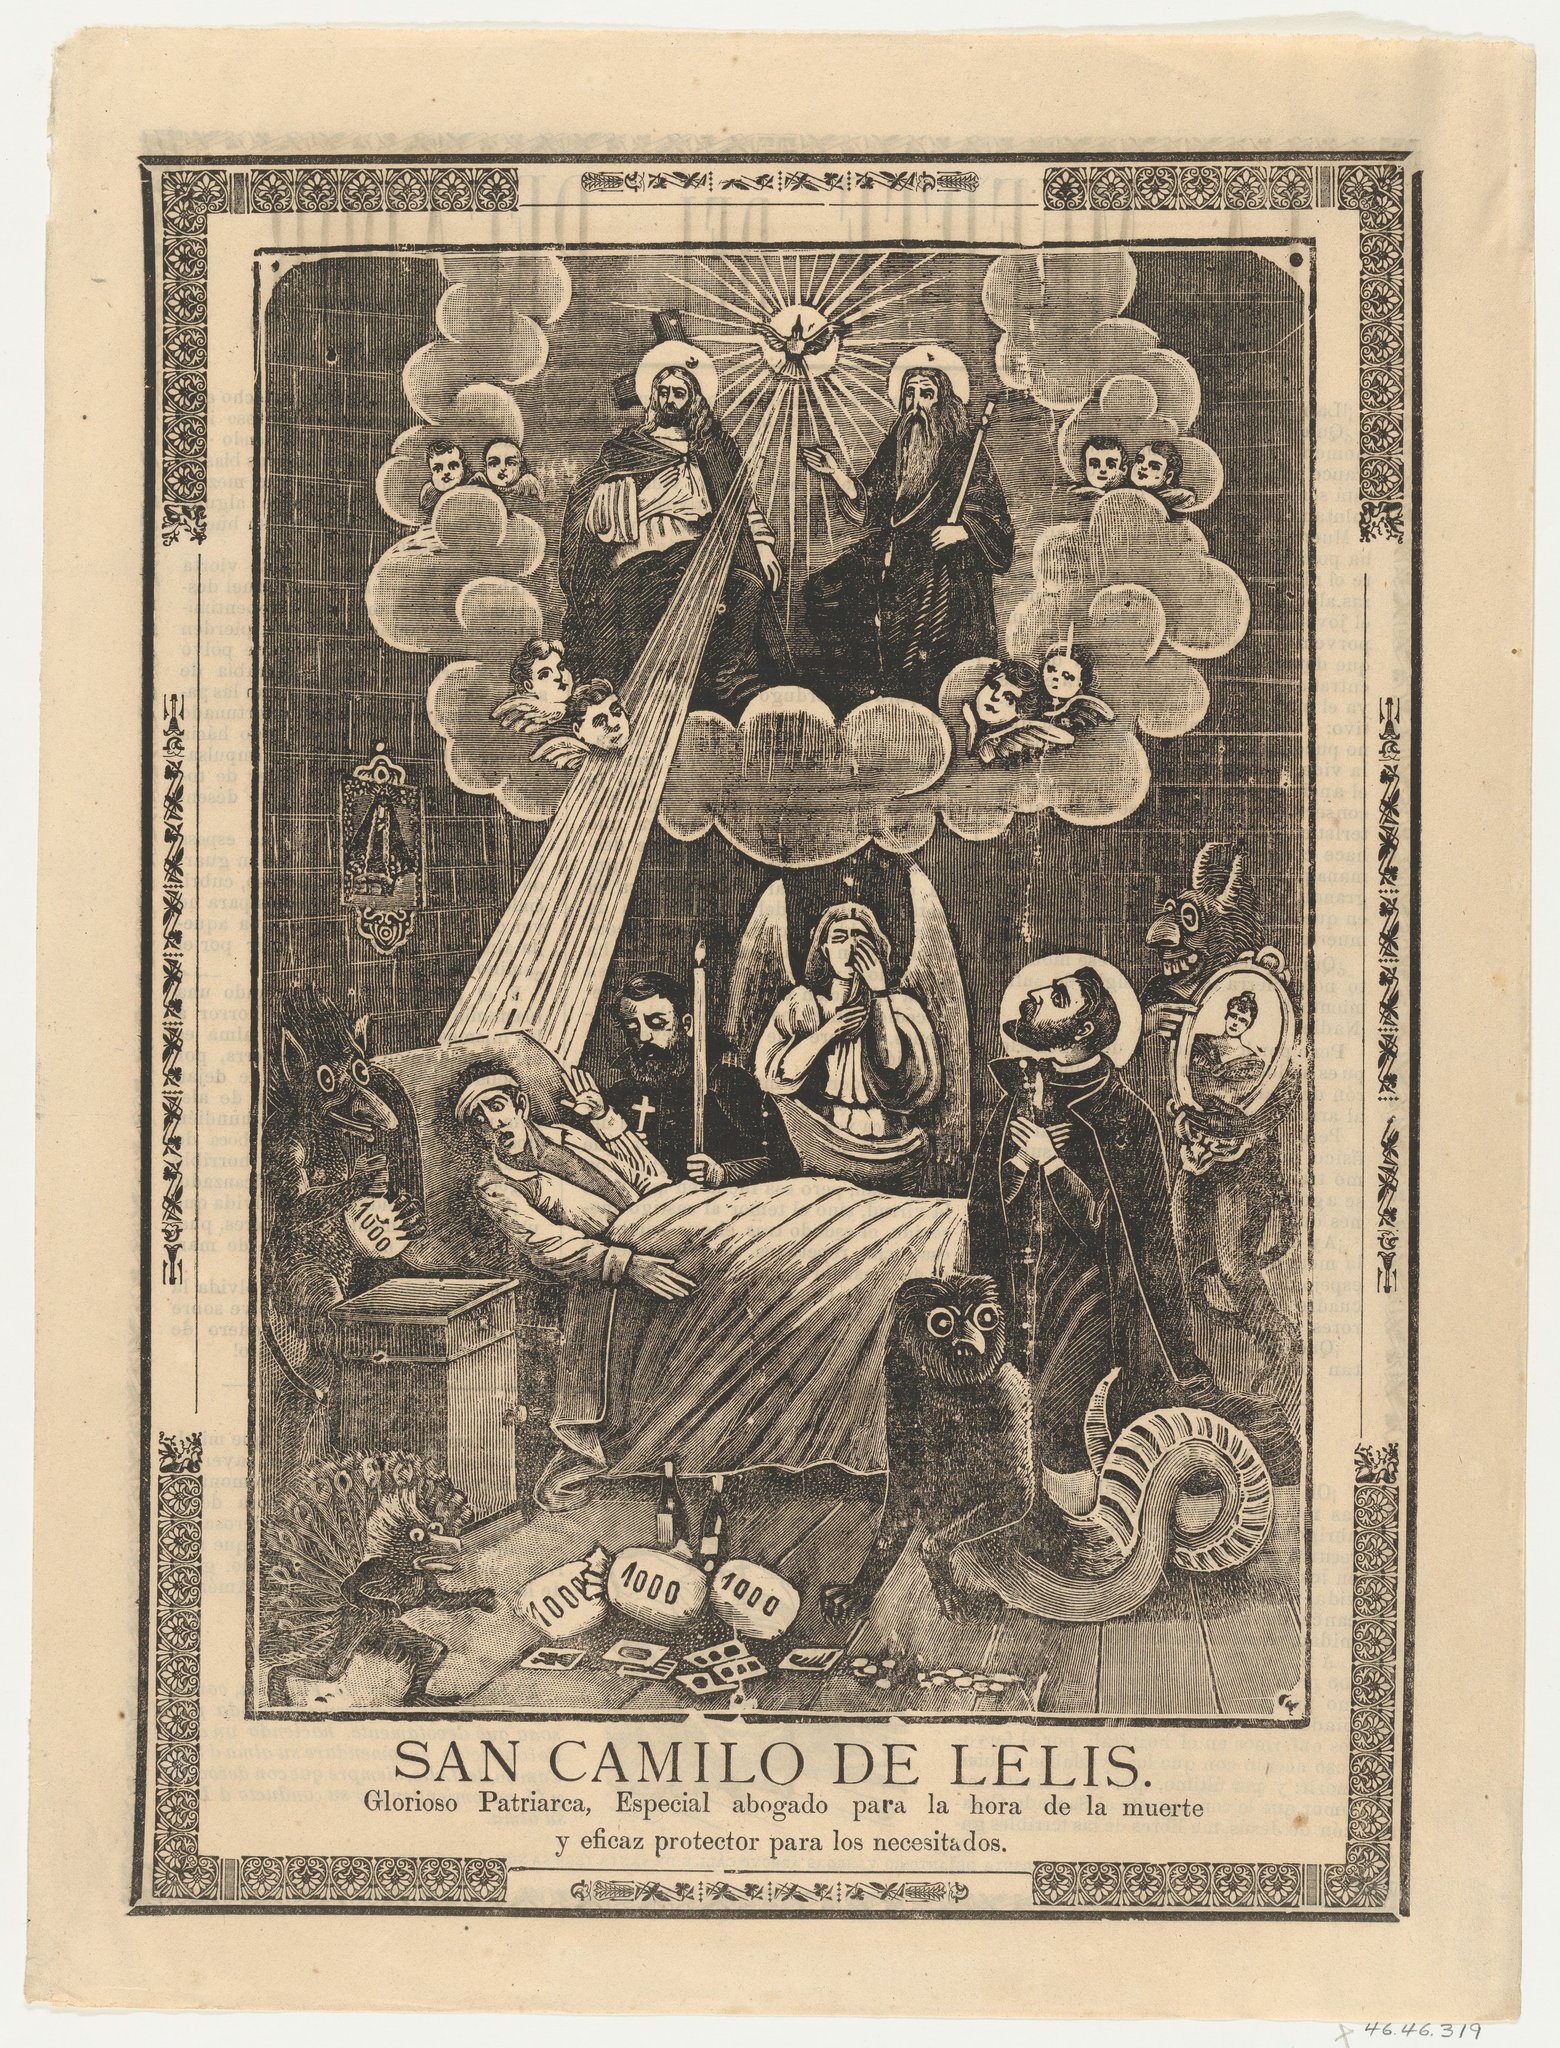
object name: print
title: Broadsheet with Saint Camilo de Lelis in bed surrounded by demons, priests and the Holy Trinity above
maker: Anonymous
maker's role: artist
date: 1900-1910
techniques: letterpress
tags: mythical creatures,angels,demons,jesus,saints